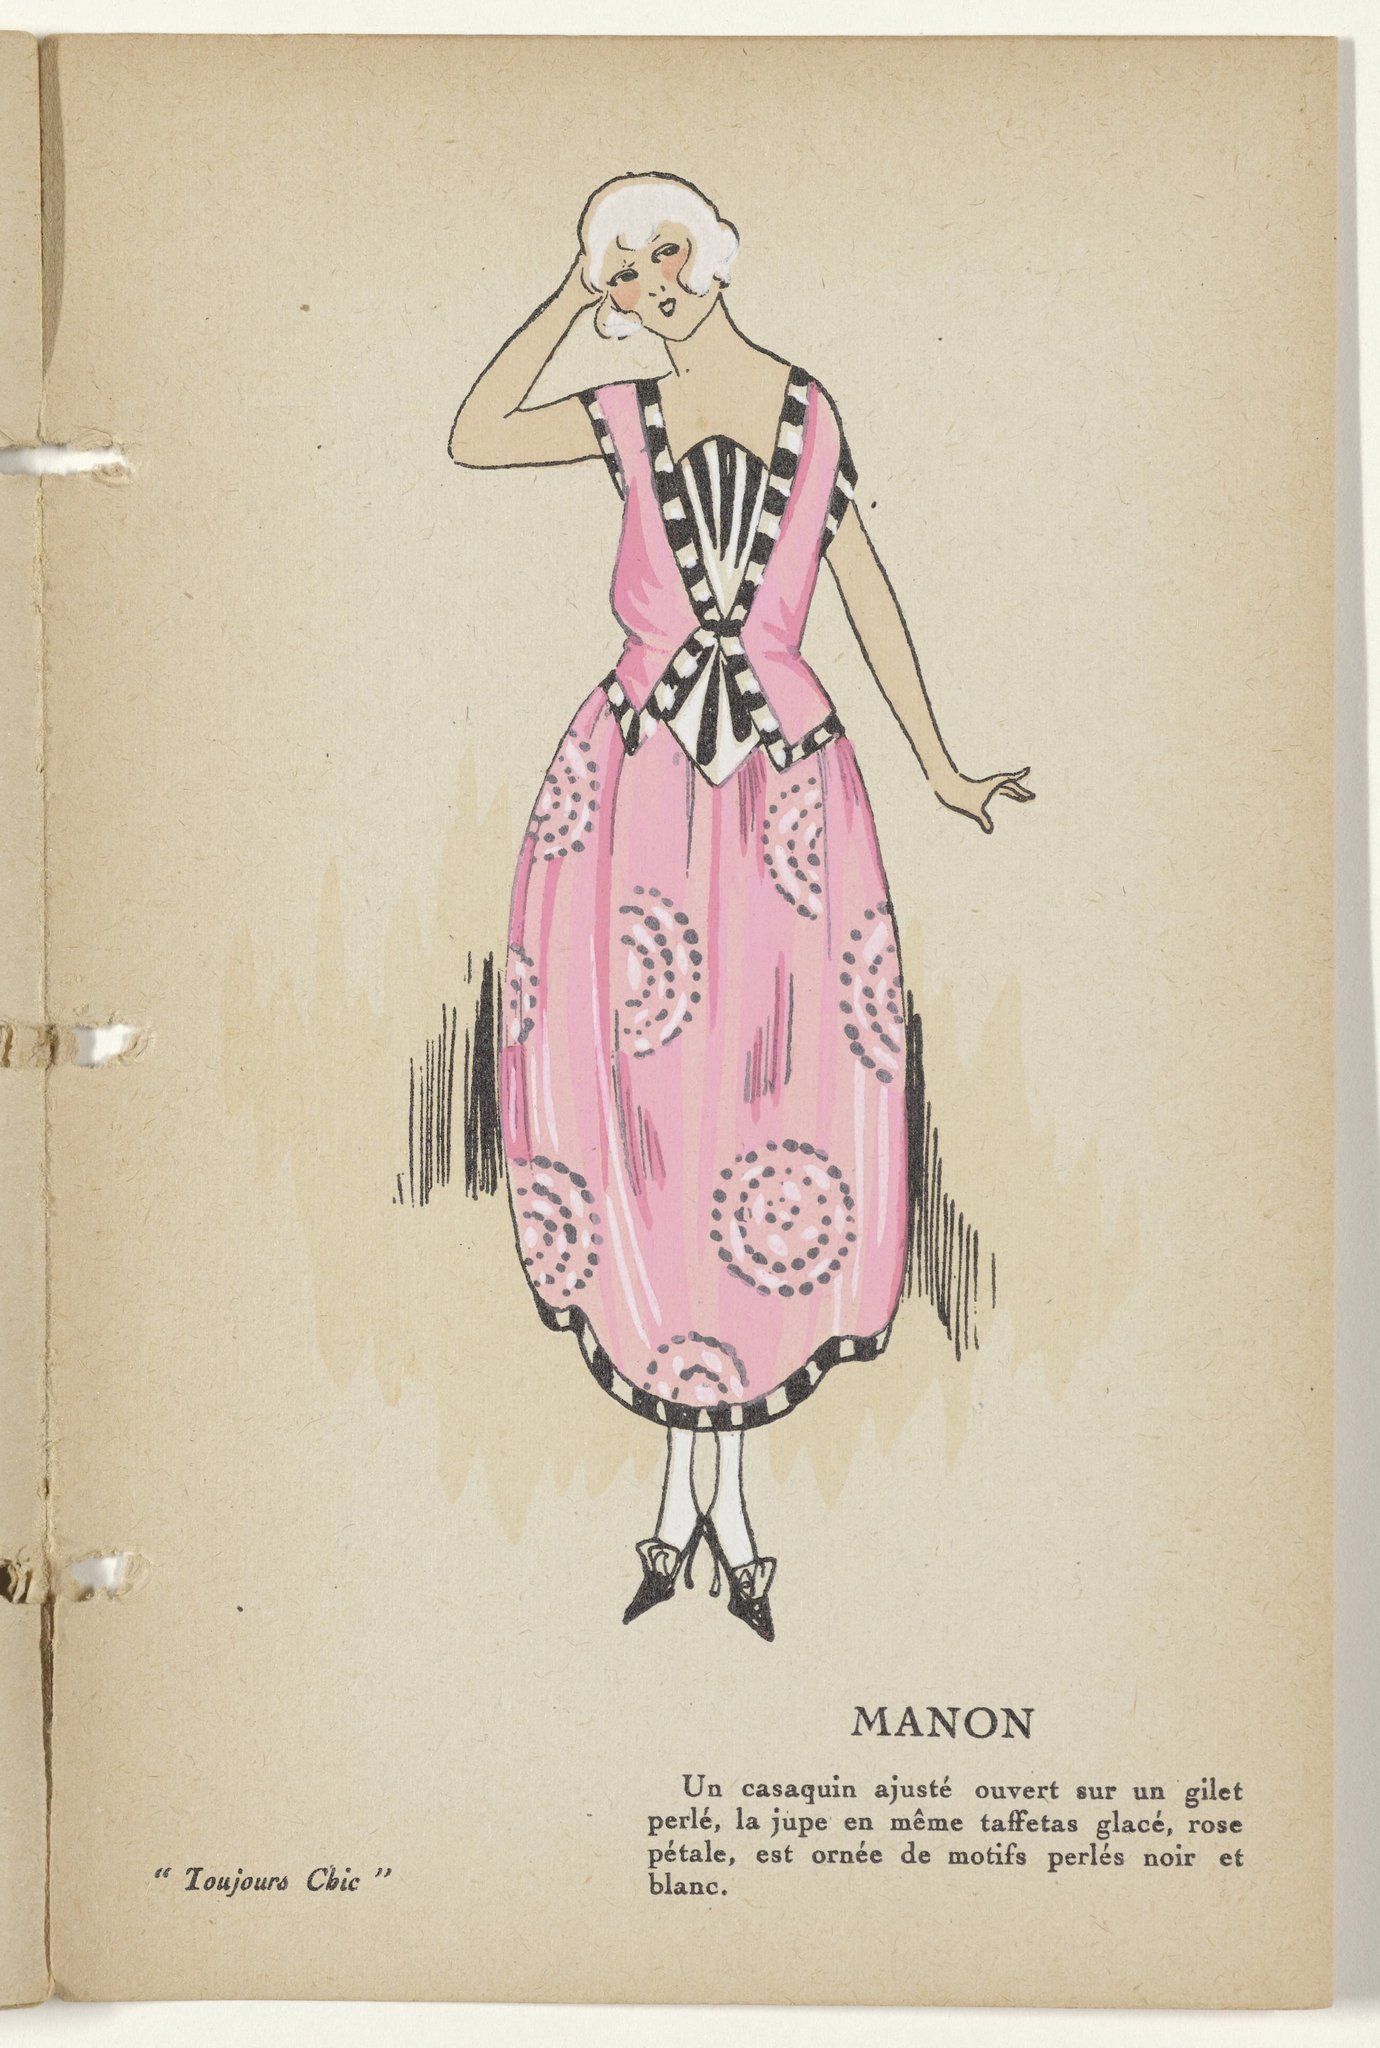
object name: fashion print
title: Toujours Chic, Toilettes de Soirées, Hiver 1921-1922: Manon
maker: g-p. joumard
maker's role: publisher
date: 1921-1922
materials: paper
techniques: letterpress printing, pochoir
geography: paris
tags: fashion plates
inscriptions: date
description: Prent uit Catalogus "Toujours Chic" waarin een overzicht van de wintermode 1921-1922 in 80 prentjes in pochoir techniek.